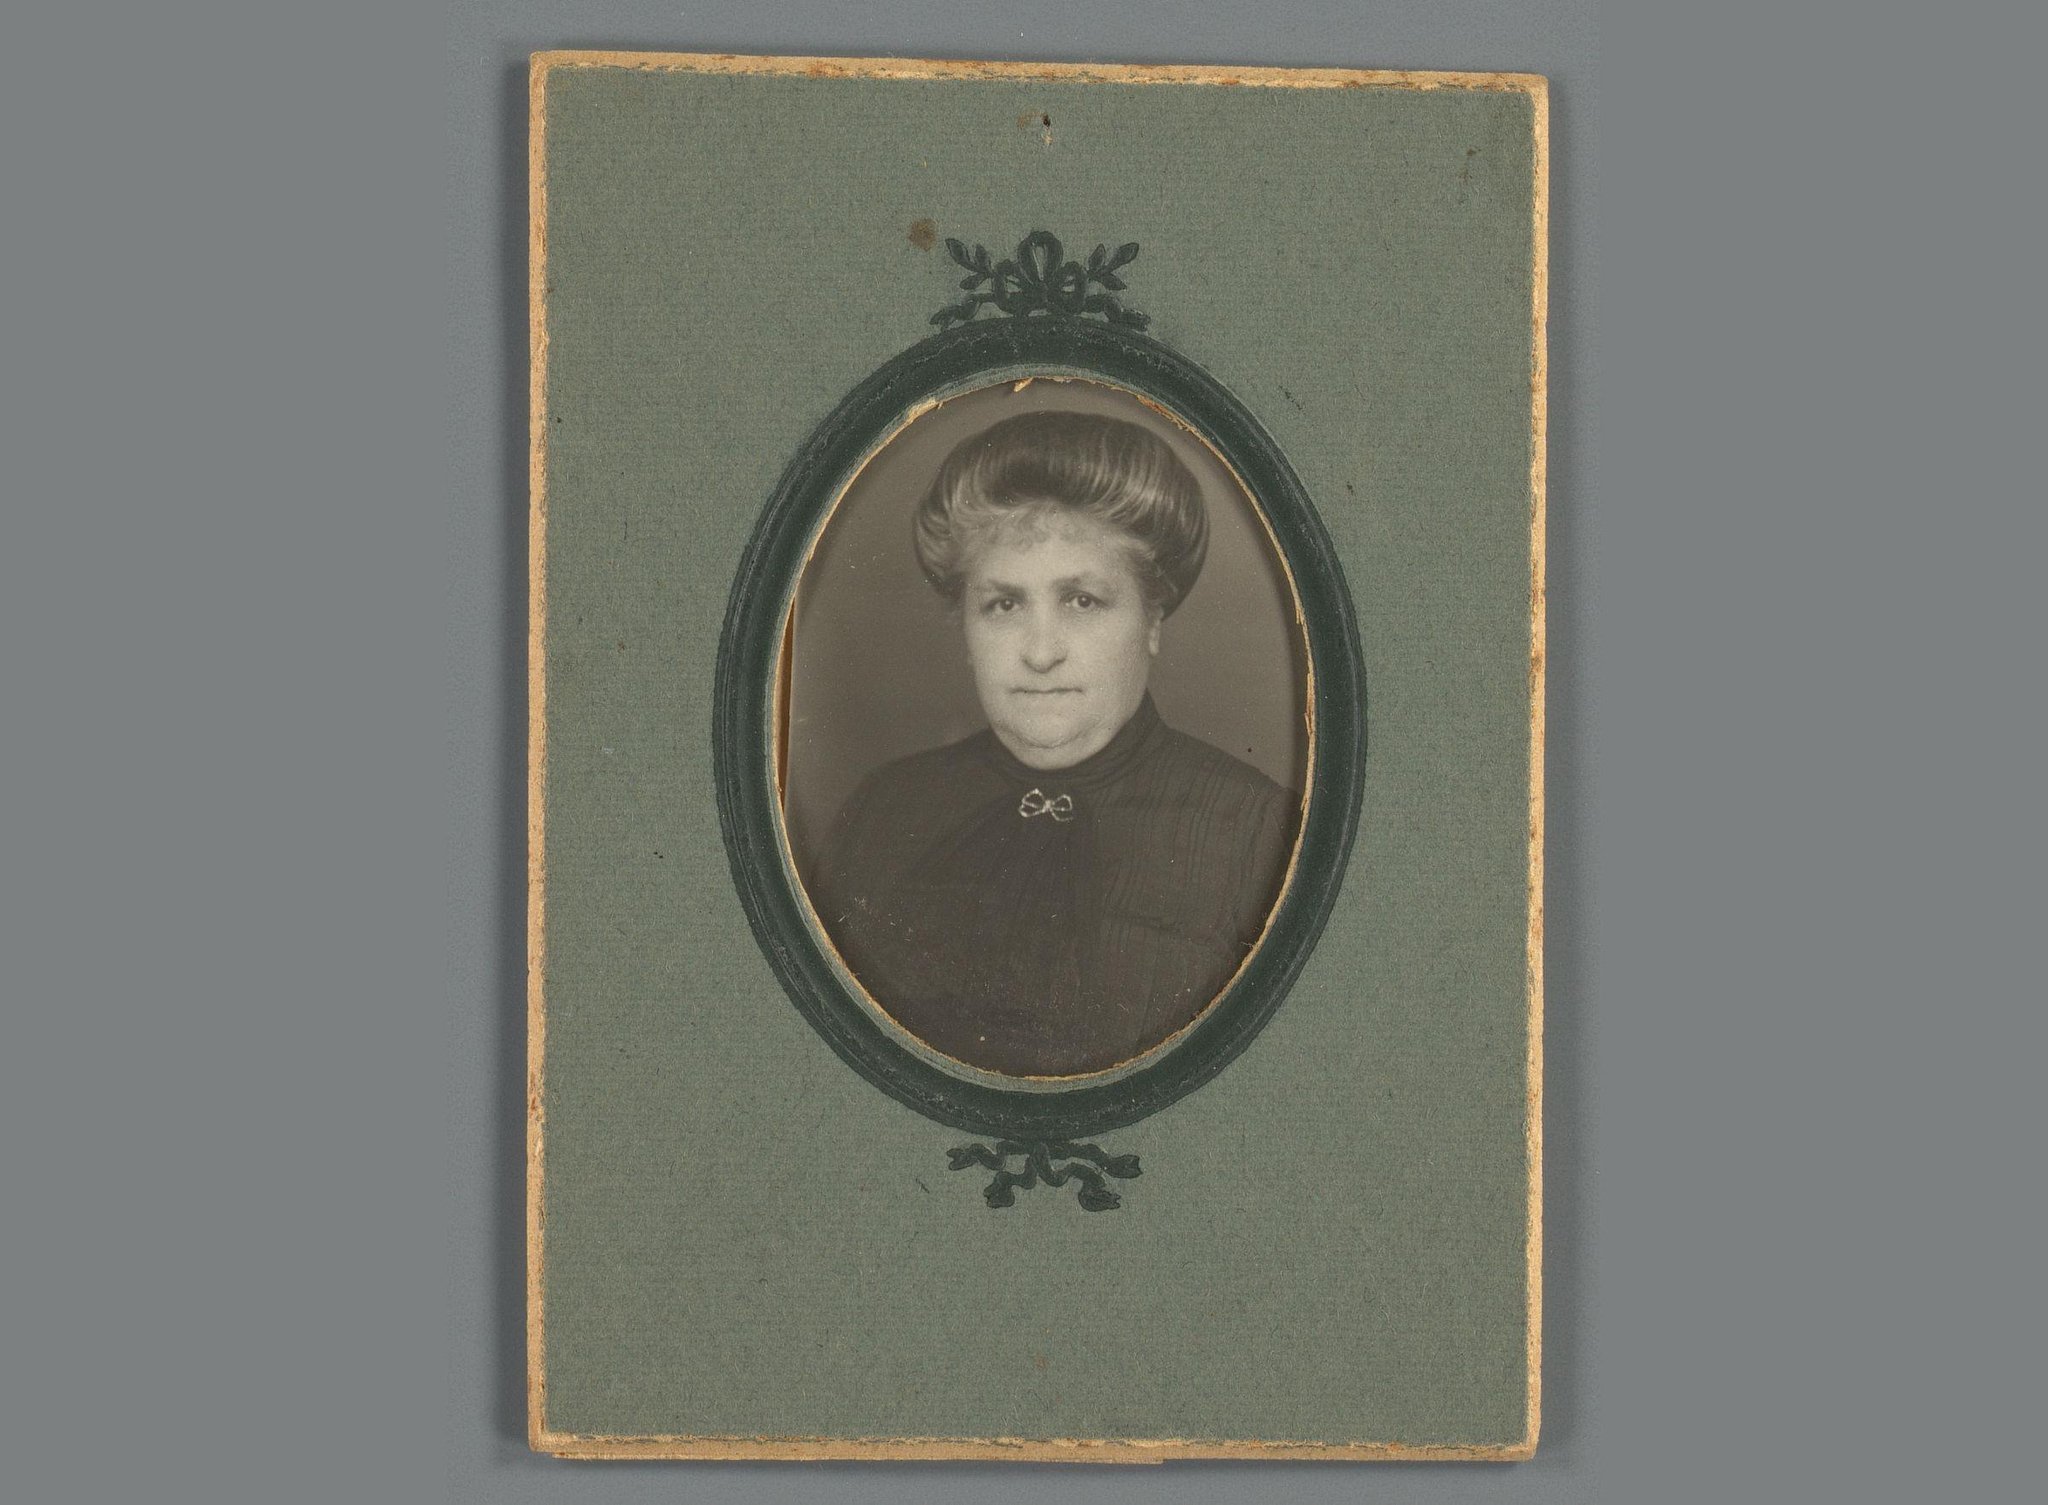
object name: photograph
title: Portret van een onbekende vrouw, gevat in een lijst van karton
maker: Anonymous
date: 1890-1920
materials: paper, cardboard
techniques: gelatin silver print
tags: adult woman, anonymous historical person portrayed